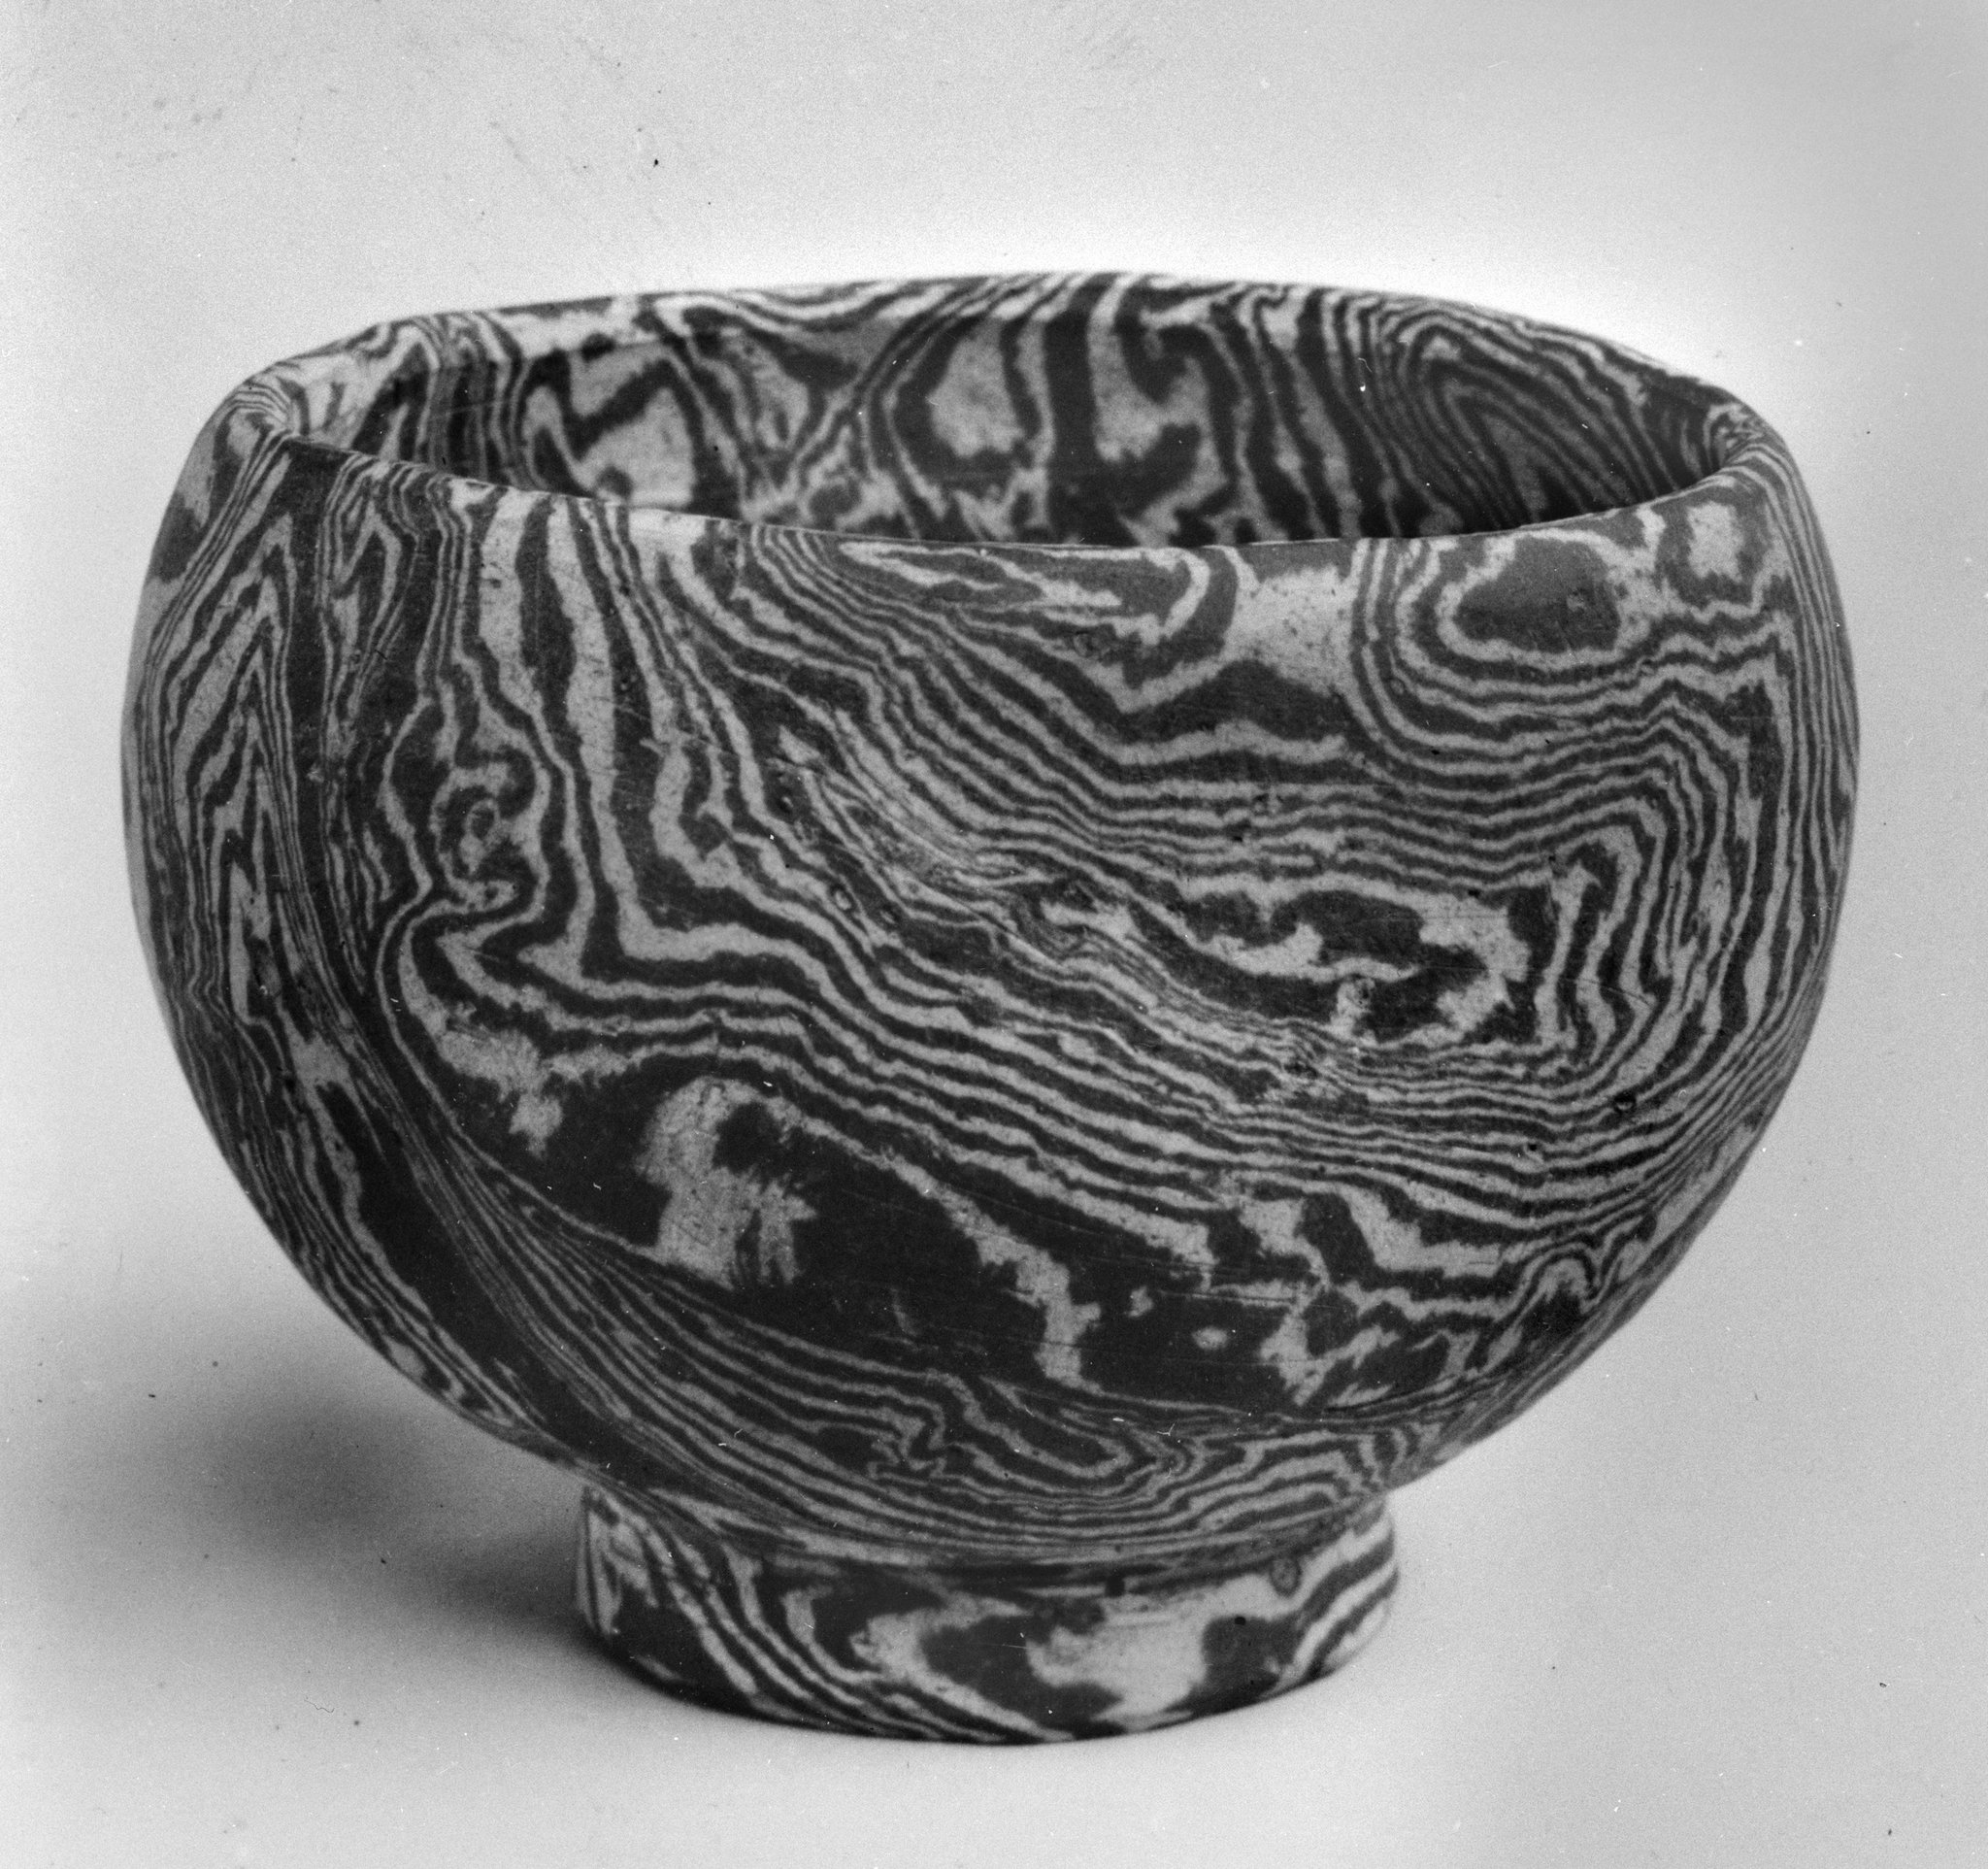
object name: cup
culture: chinese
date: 601-800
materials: earthenware, glaze